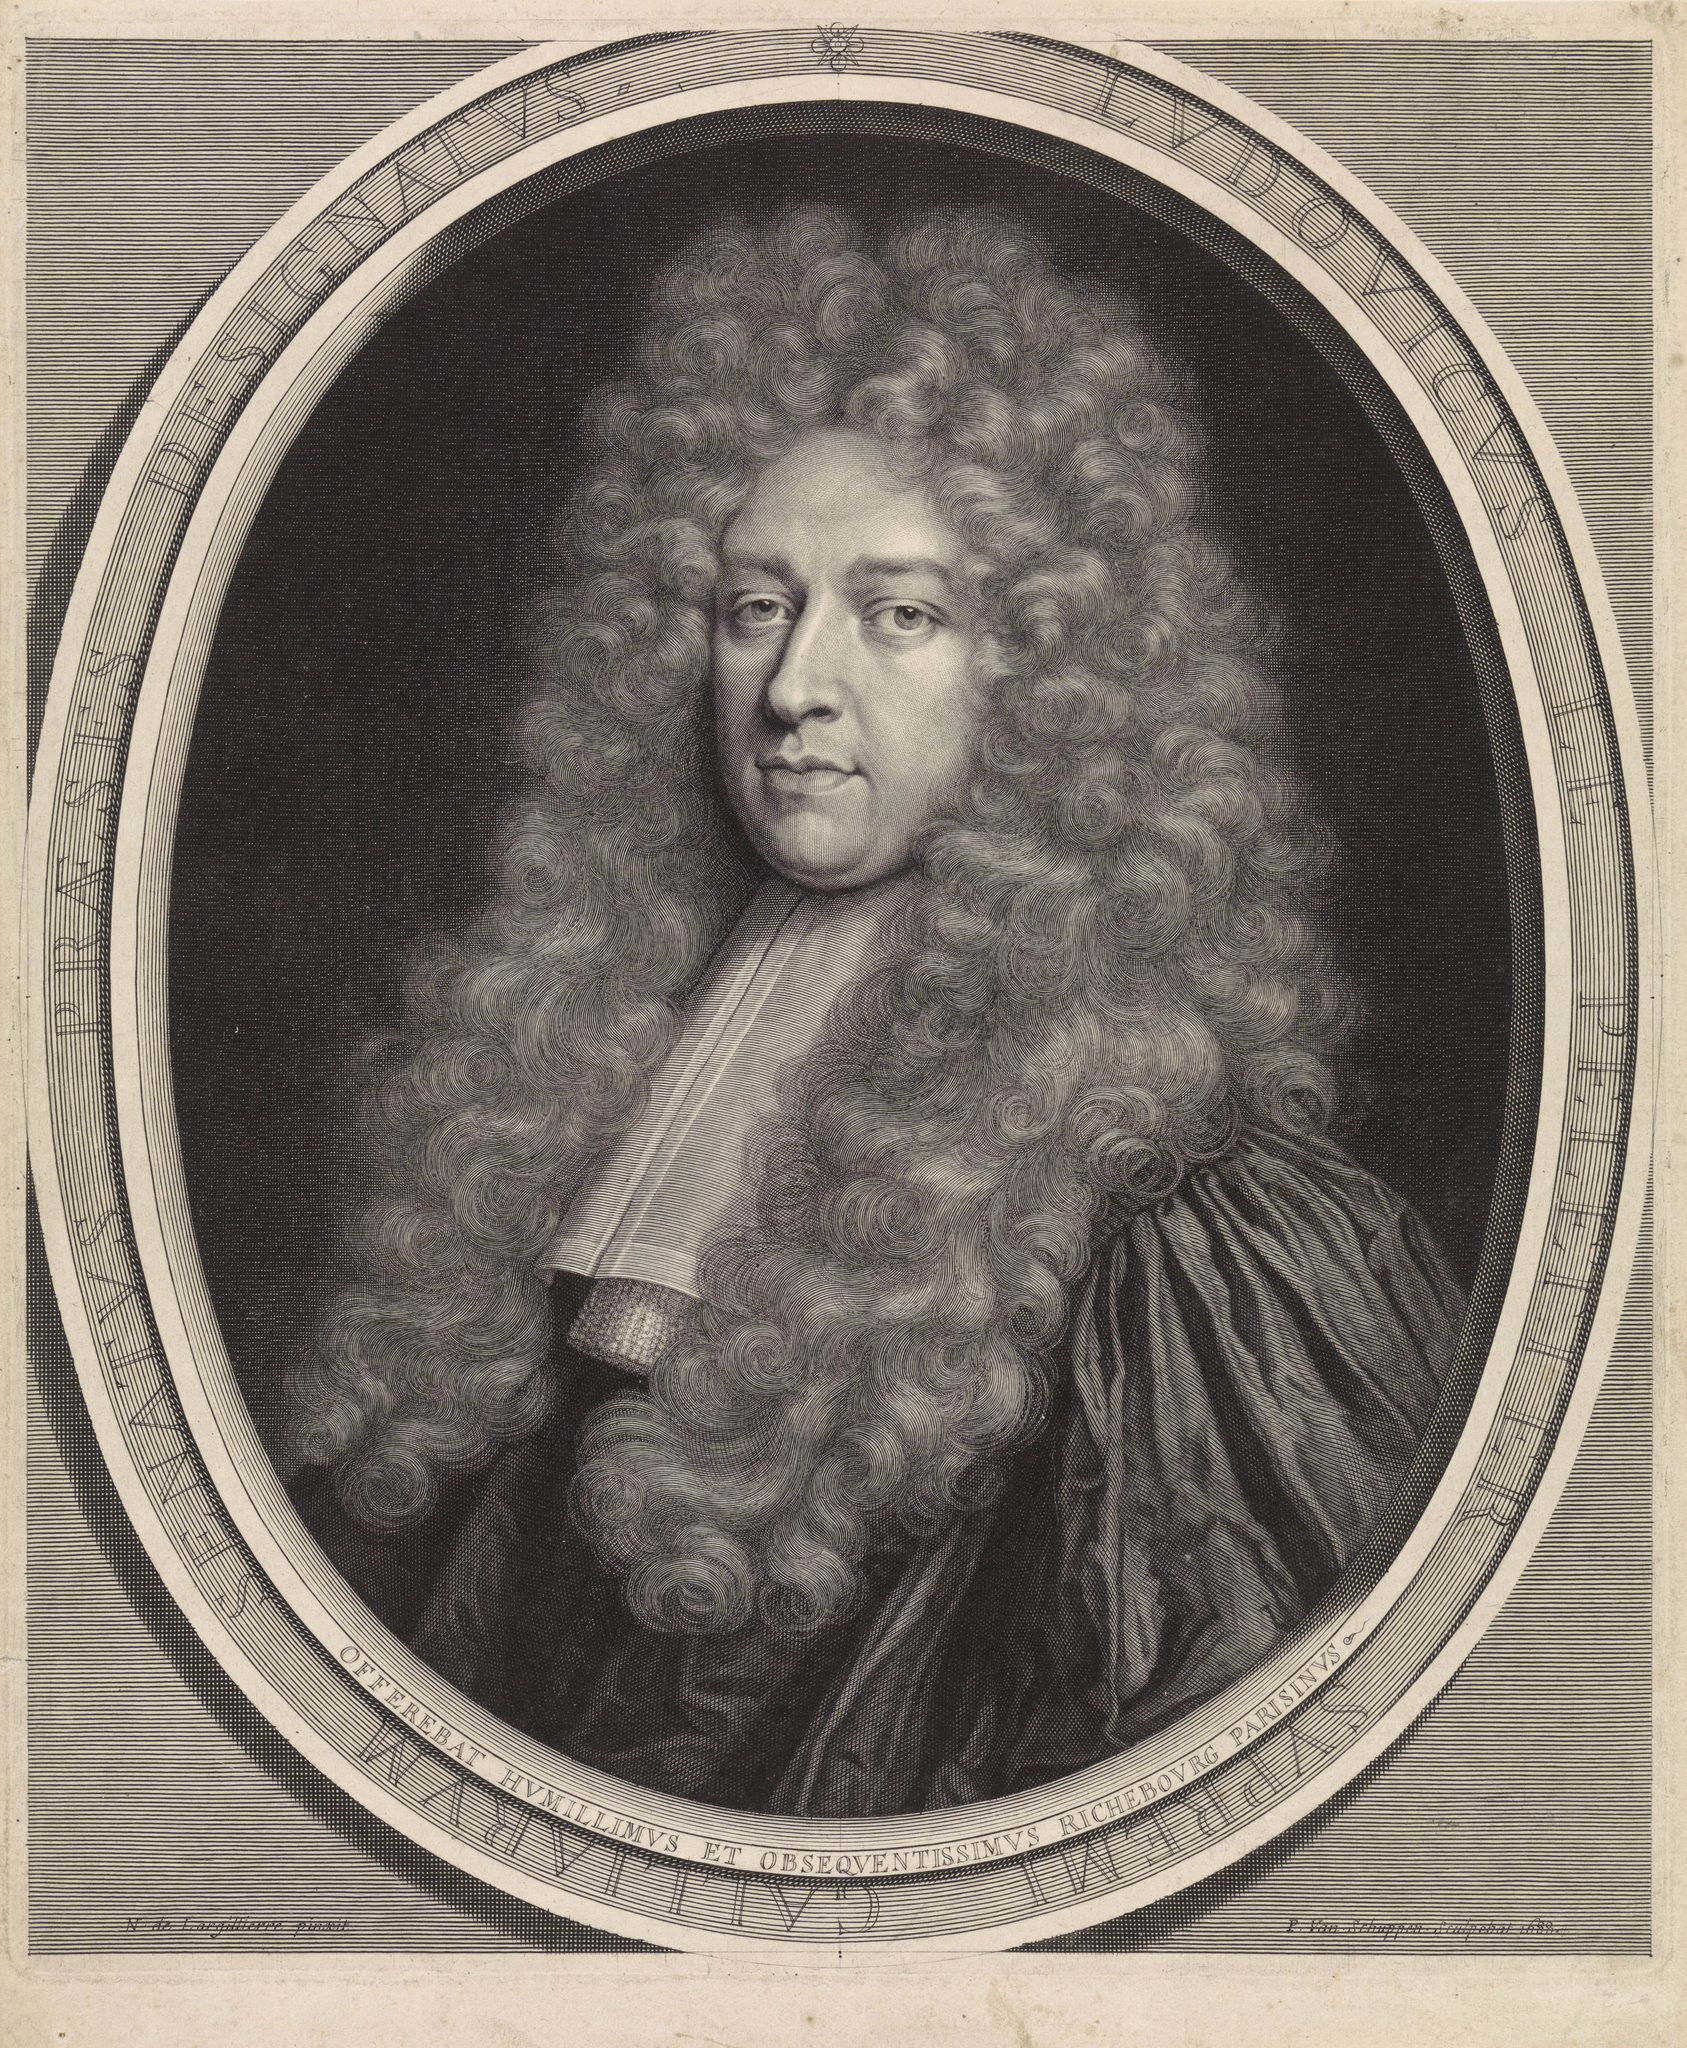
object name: print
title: Portret van Louis (II) Urbain Le Peletier de Rosanbo, president van het Parlement in Parijs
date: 1608-1688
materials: paper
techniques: engraving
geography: paris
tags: louis urbain marquis le peletier de rosanbo (ii)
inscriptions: collector's mark: ‘Soliman 1830’ Lugt 1682, collector's mark: Lugt 2228, collector's mark: ‘N AP’ Lugt 2045